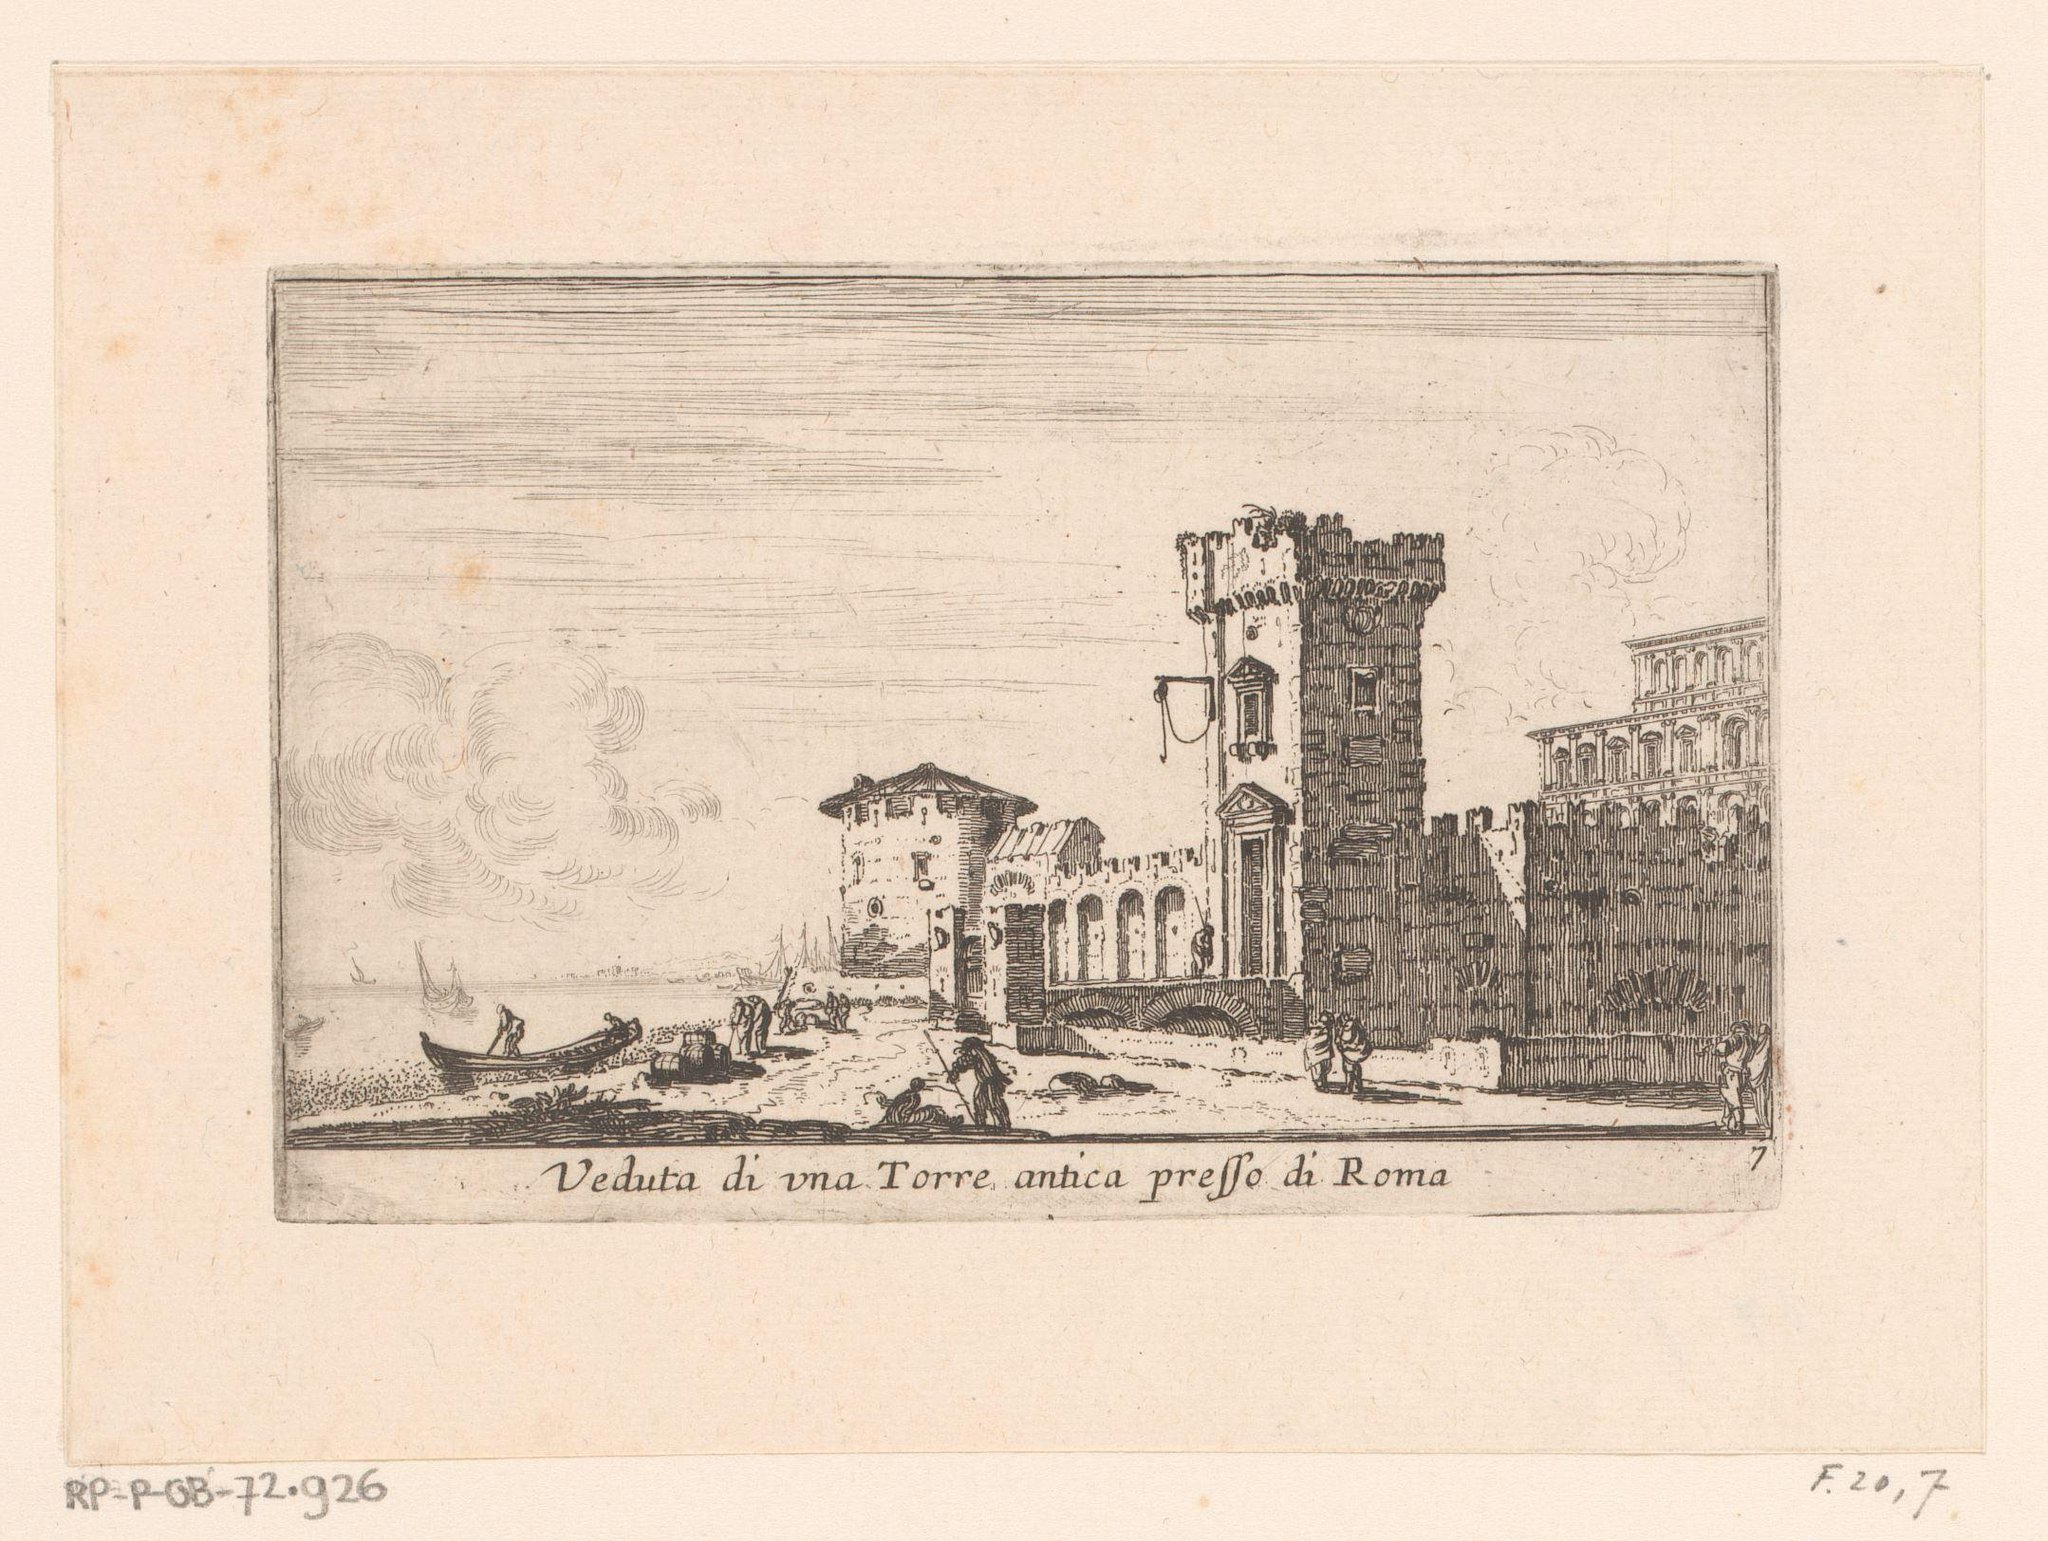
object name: print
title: Diverse gezichten op Frankrijk en Italië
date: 1631-1657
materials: paper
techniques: etching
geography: france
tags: landscape with tower or castle, rome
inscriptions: collector's mark: Lugt 240